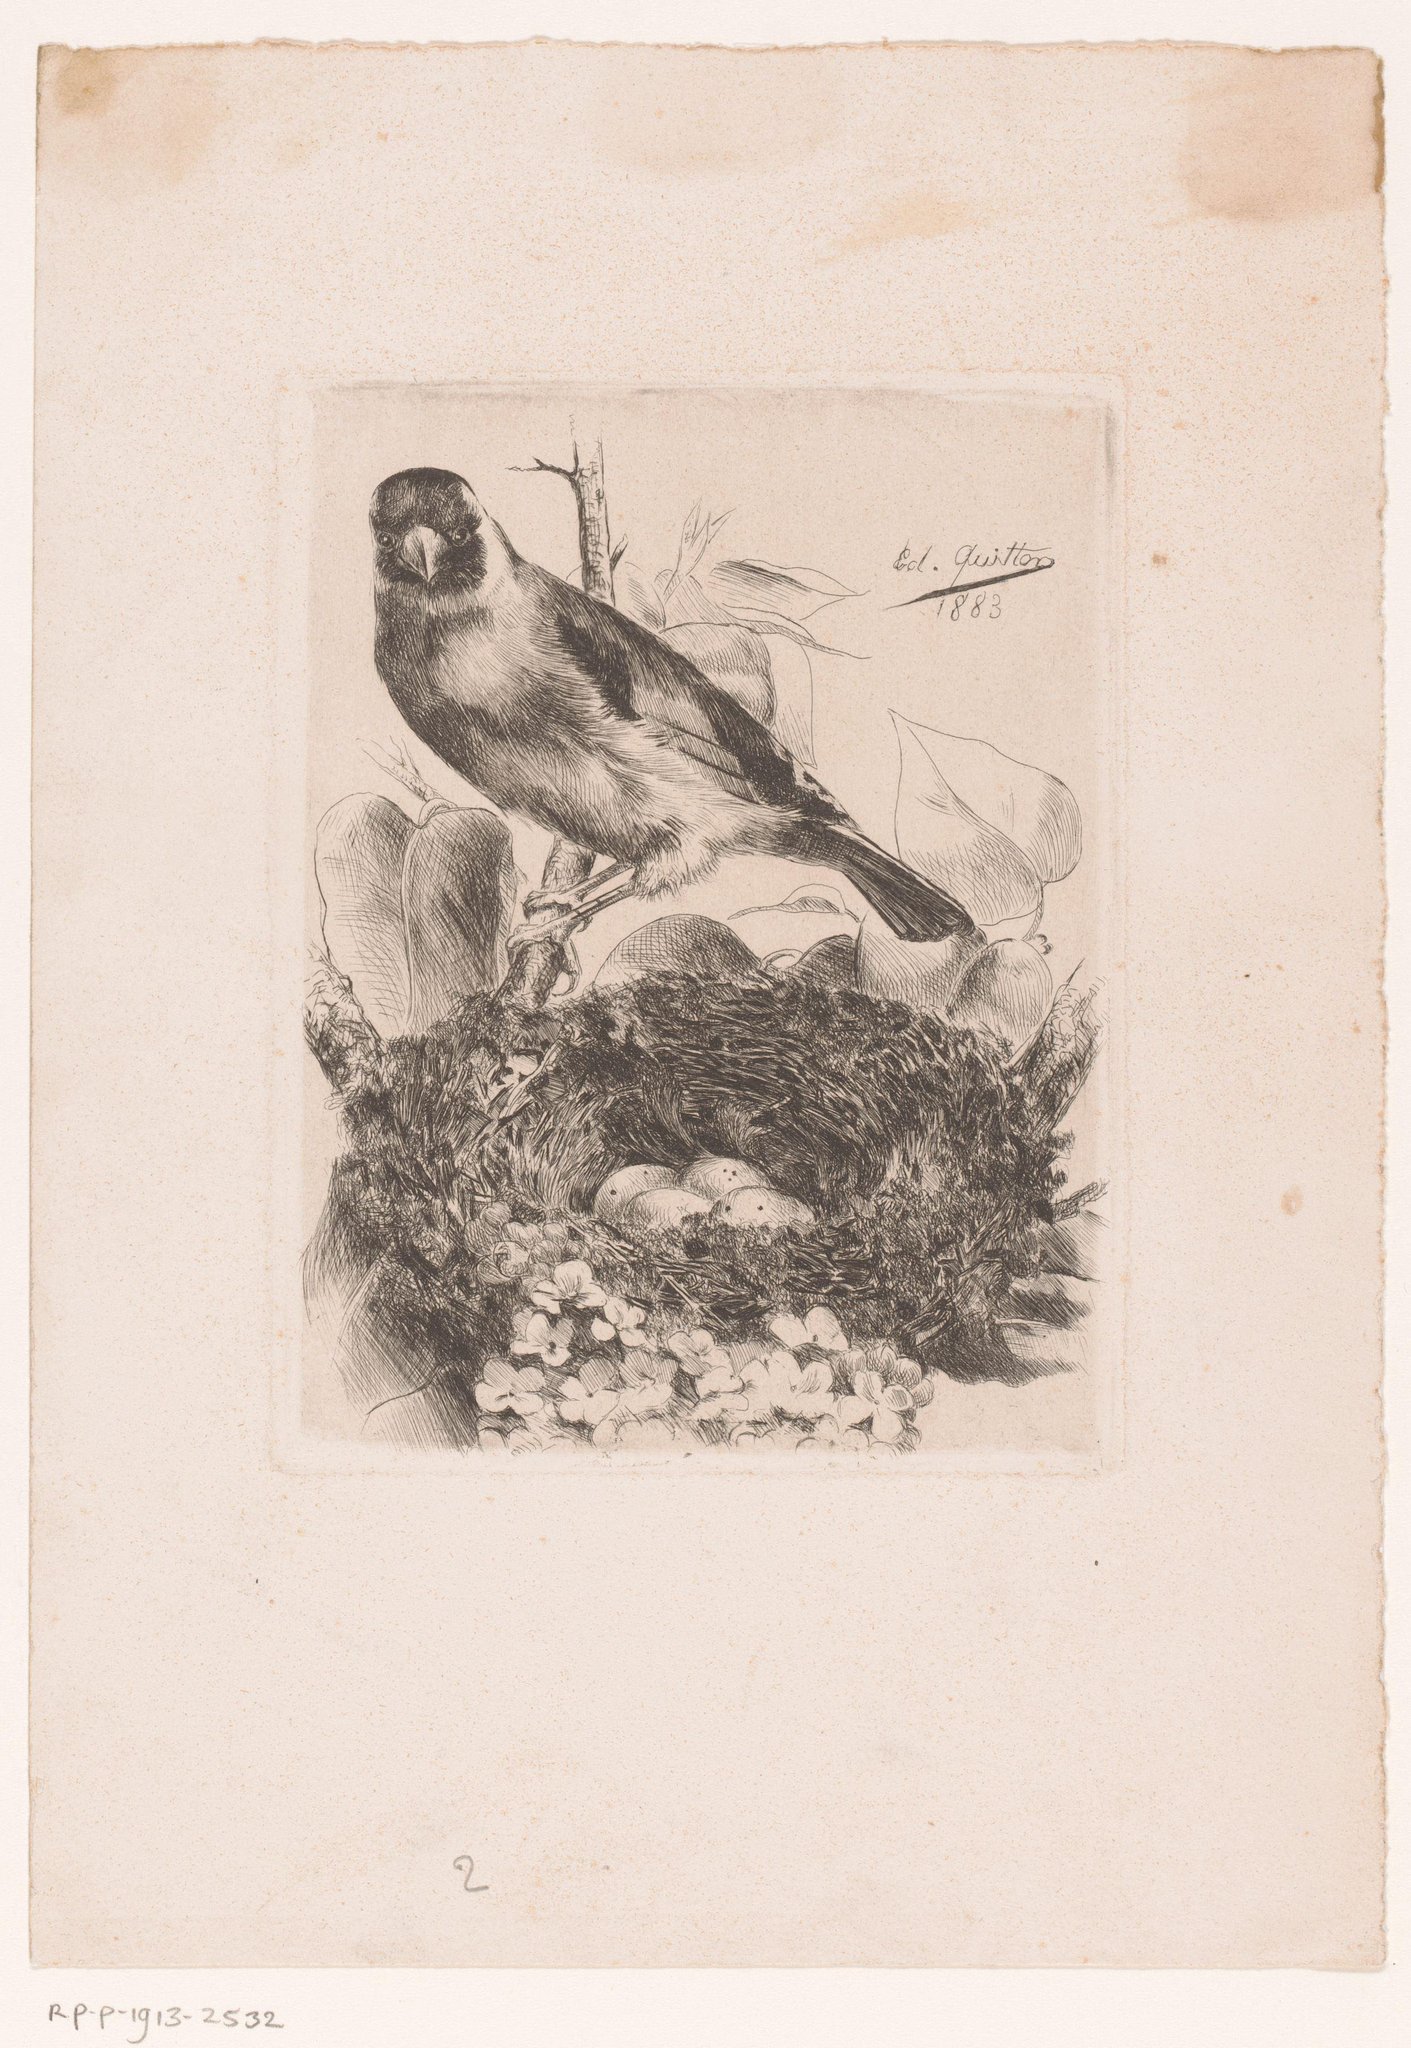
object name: print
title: Vogel bij een nest met vier eieren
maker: edward quitton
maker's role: print maker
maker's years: 1842-1934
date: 1883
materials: paper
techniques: etching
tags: birds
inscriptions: collector's mark: Lugt 2228